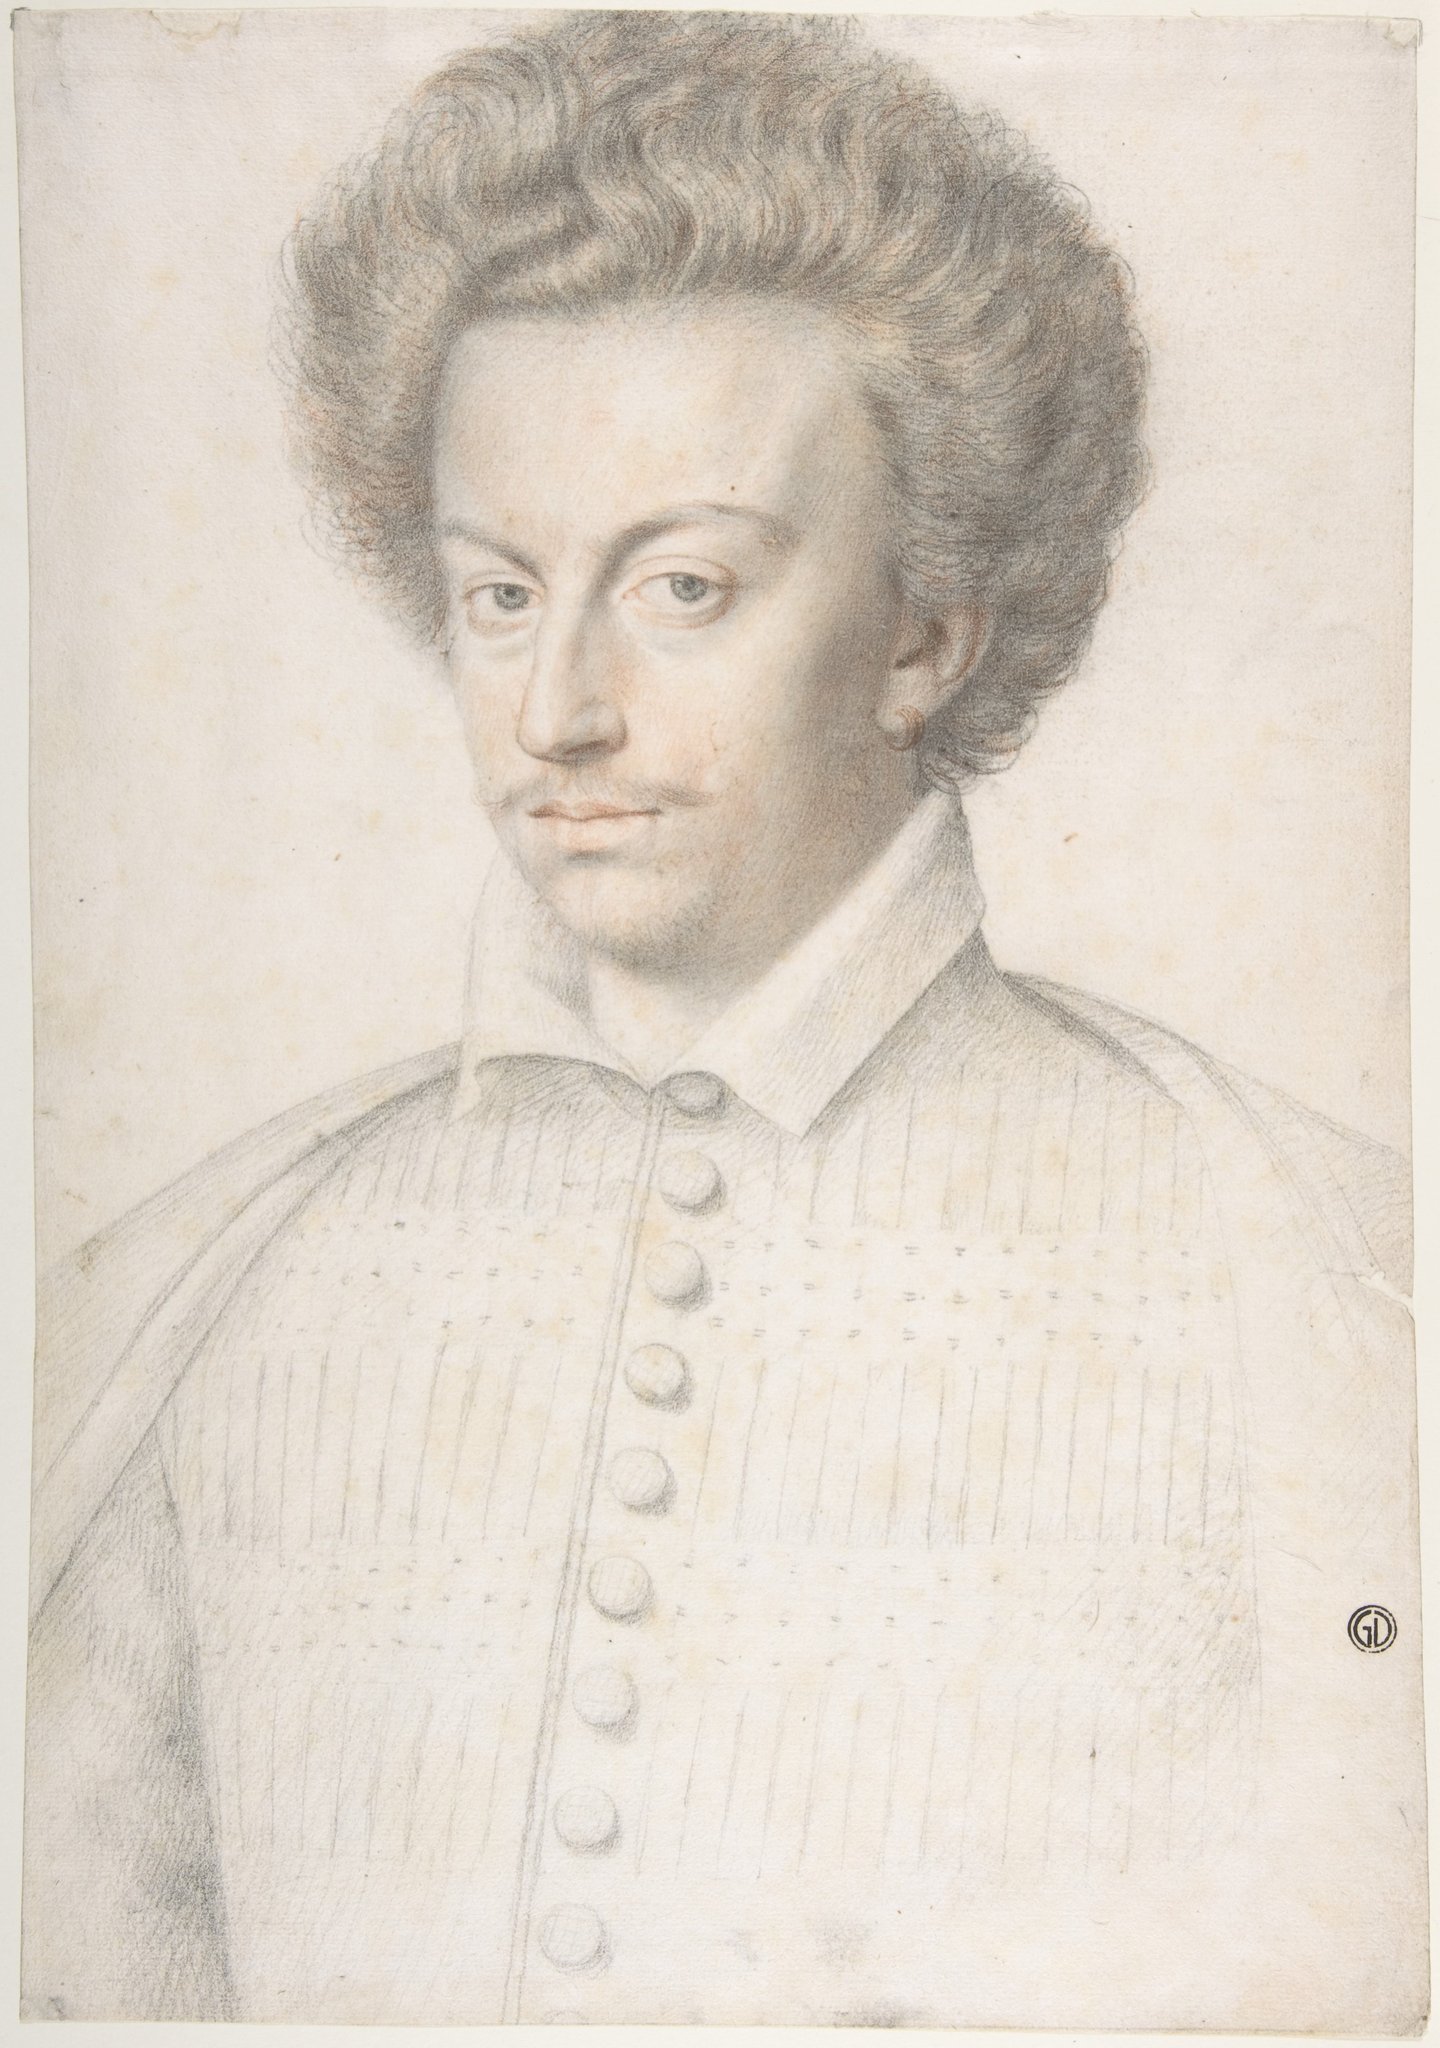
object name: drawing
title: Portrait of a Man (Louis de Lorraine?, 1555–1588)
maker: anonymous, french, 16th century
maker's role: artist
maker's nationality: french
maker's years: 1500-1600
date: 1500-1599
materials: chalk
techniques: heightening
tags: men,portraits